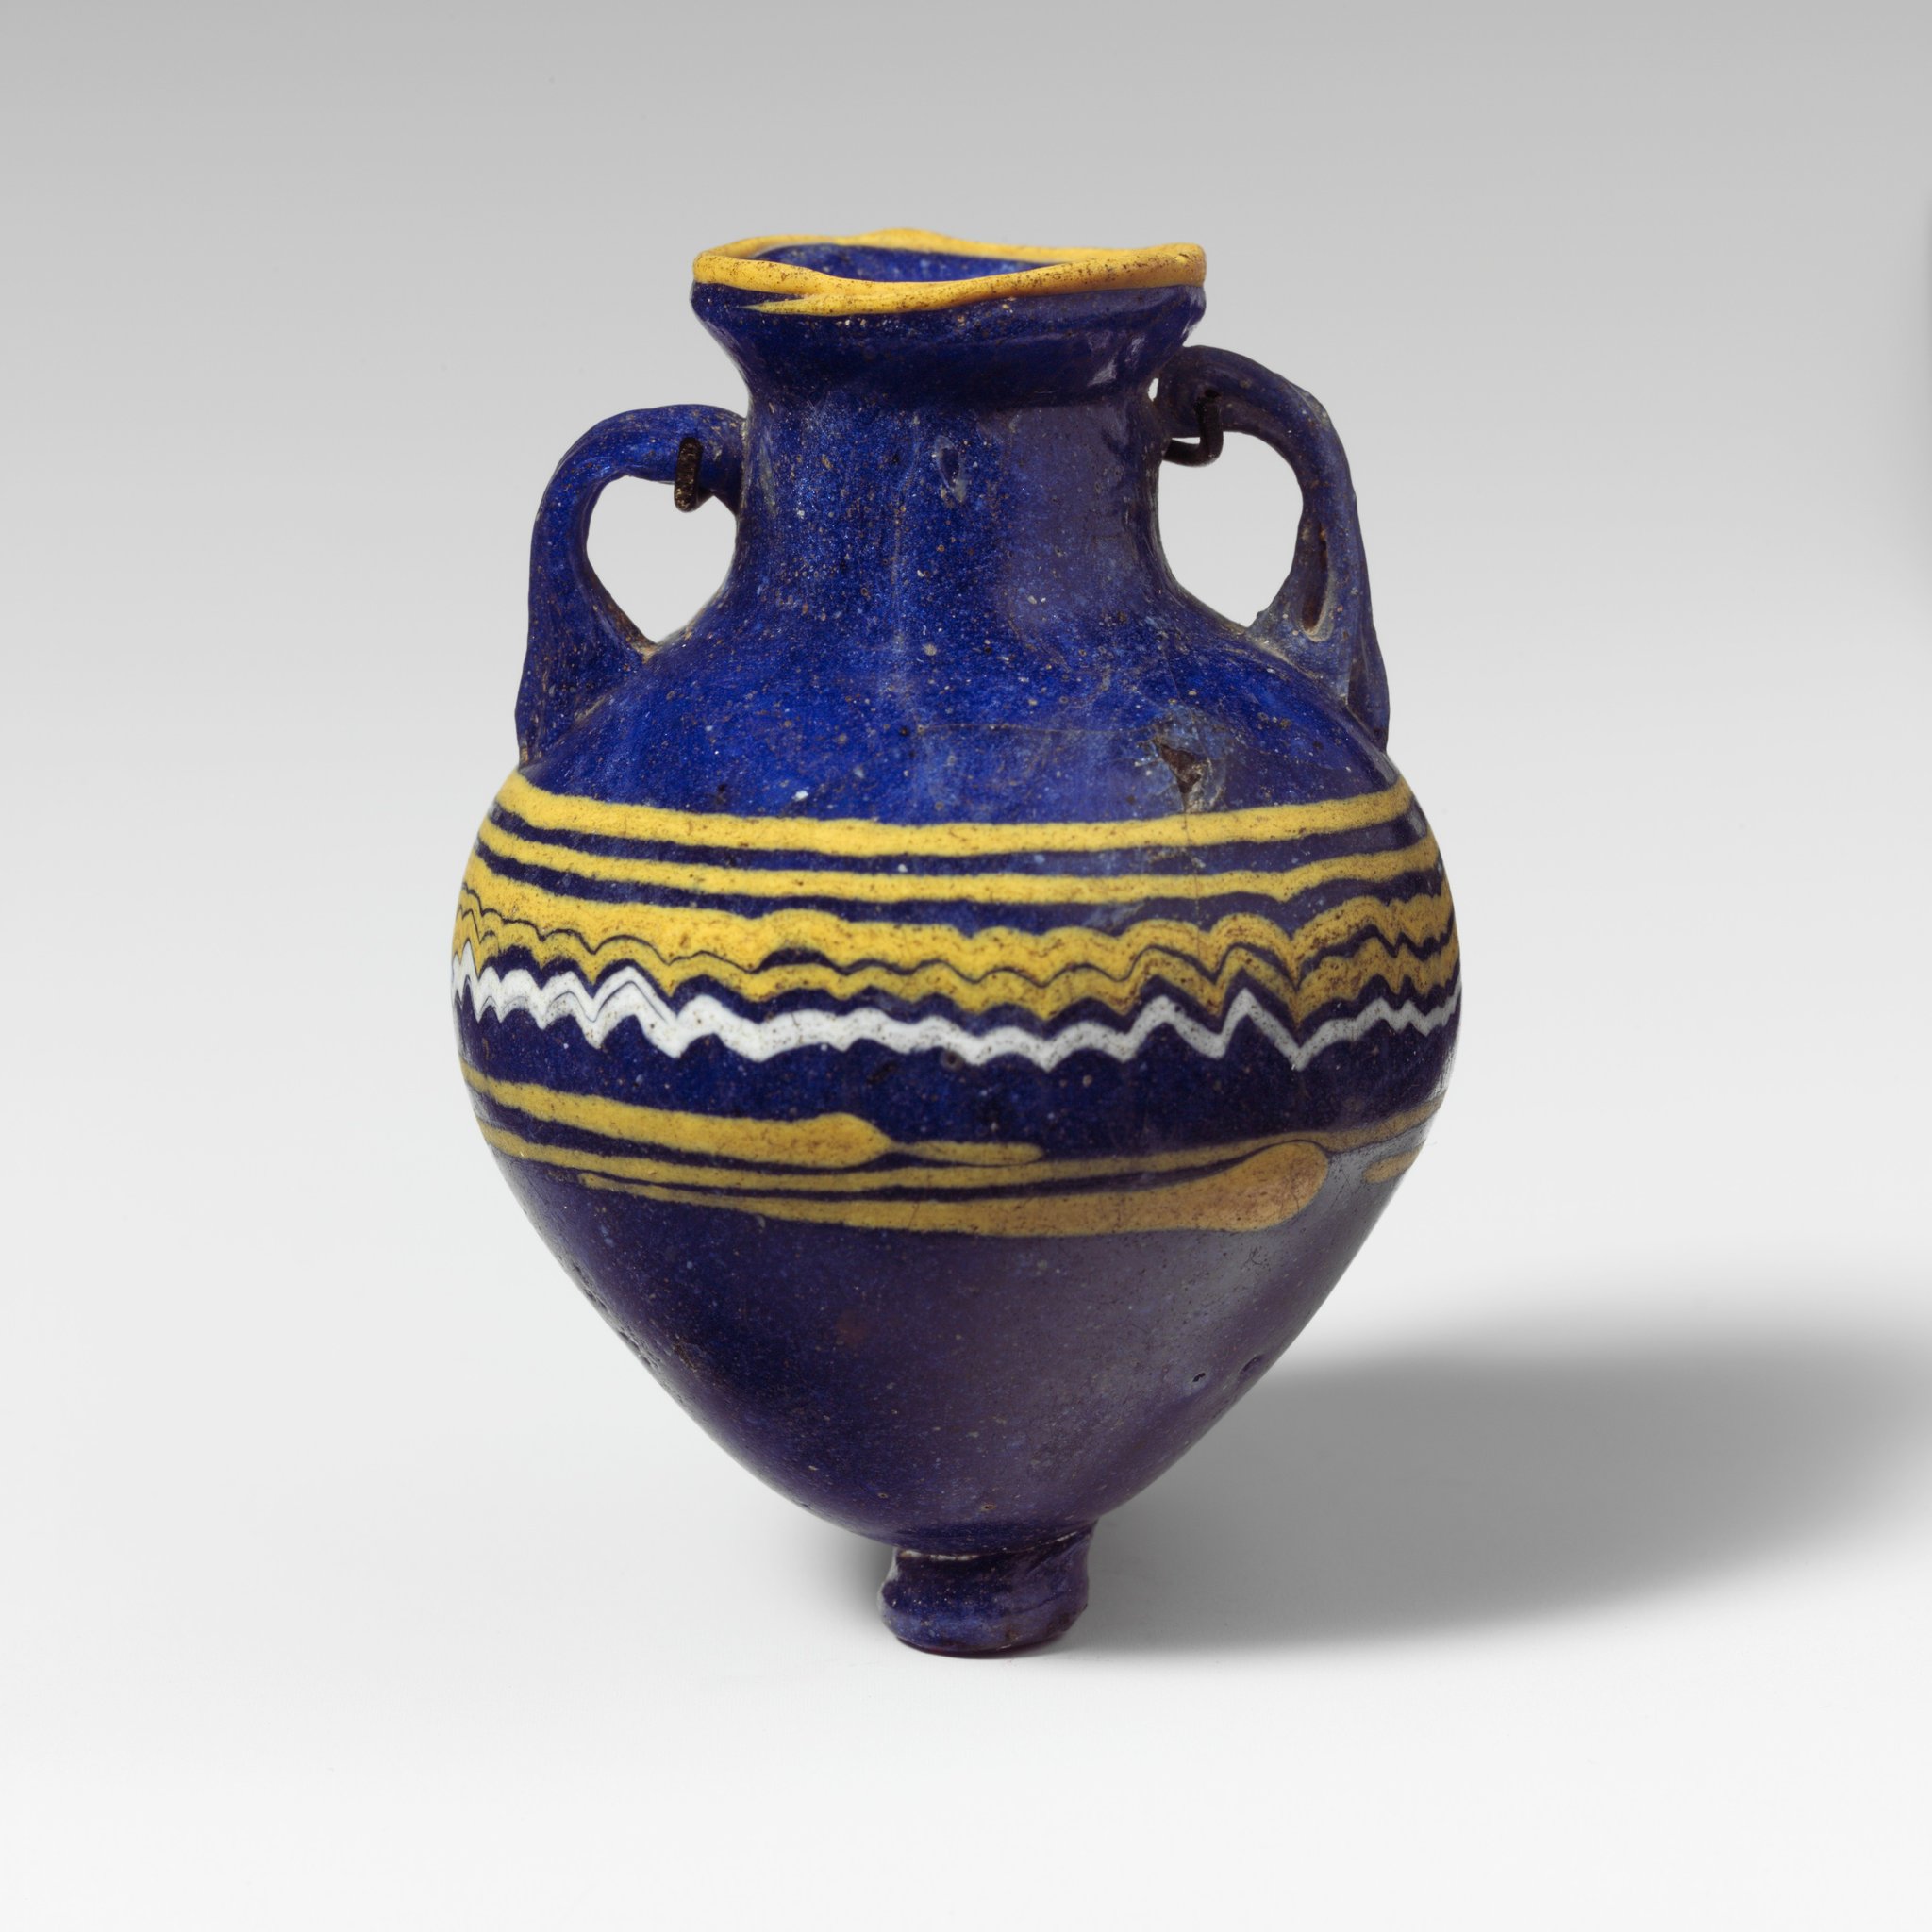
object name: amphoriskos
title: Glass amphoriskos (perfume bottle)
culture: greek, eastern mediterranean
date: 534-401 BCE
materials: glass